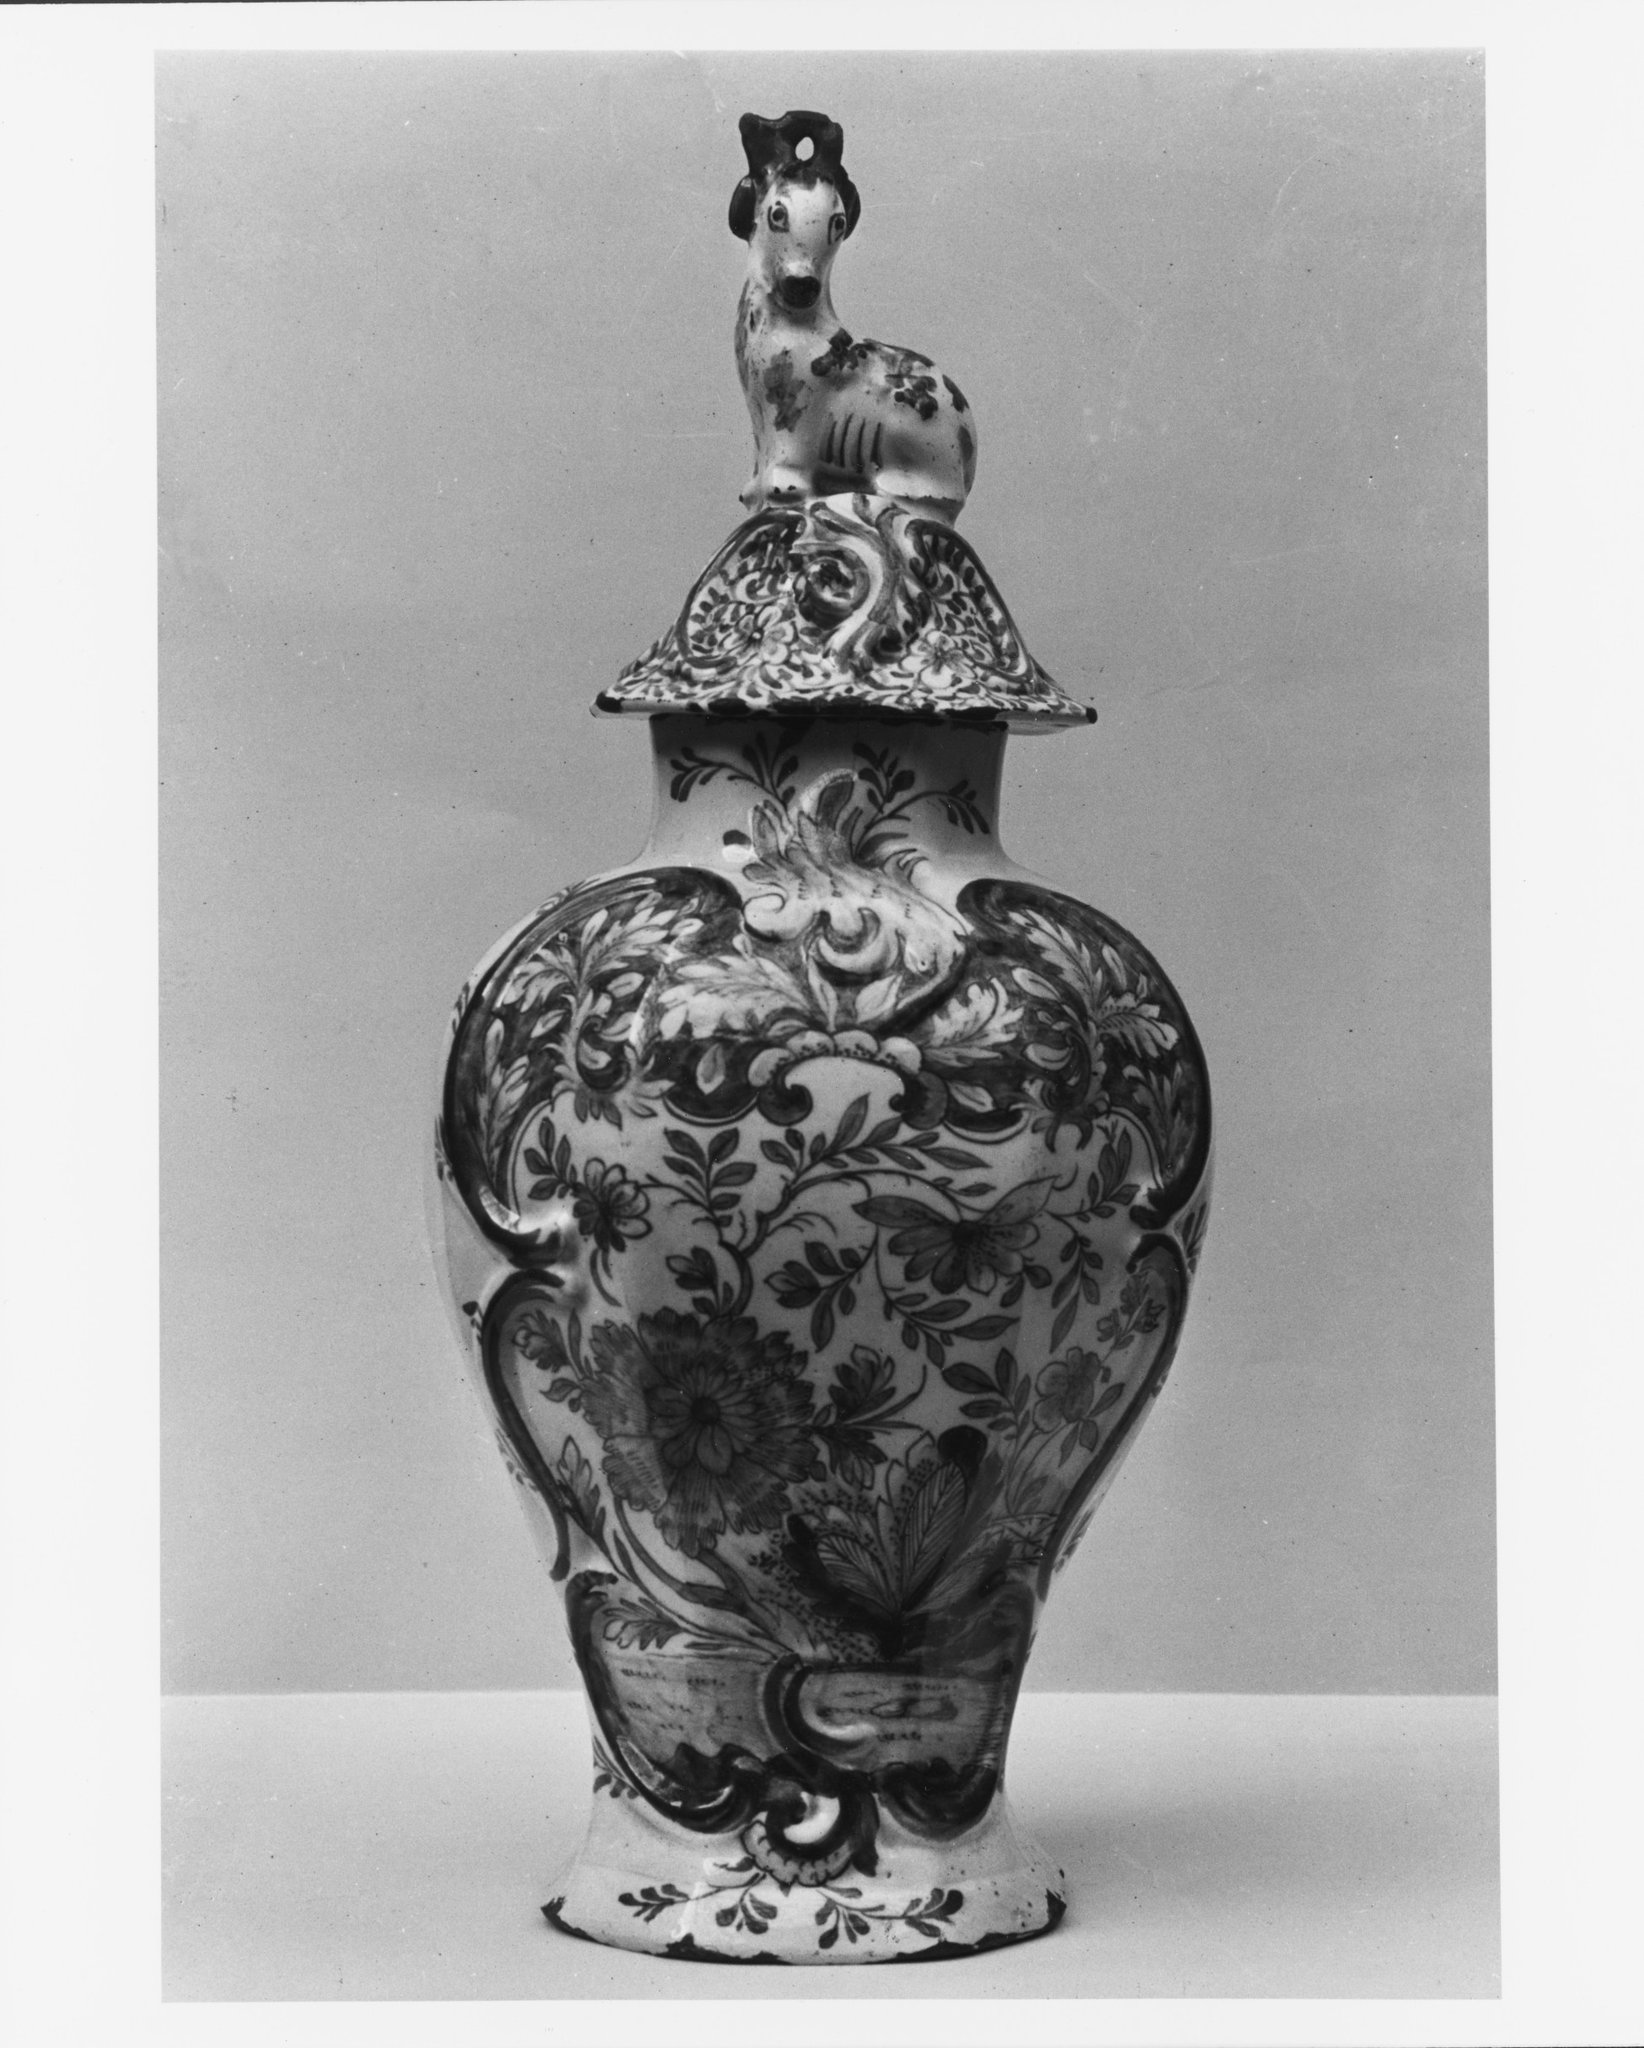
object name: jar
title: Covered Jar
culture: dutch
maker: justus brouwer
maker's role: designer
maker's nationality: dutch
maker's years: 1739-1775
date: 1739-1775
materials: earthenware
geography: netherlands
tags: animals,flowers